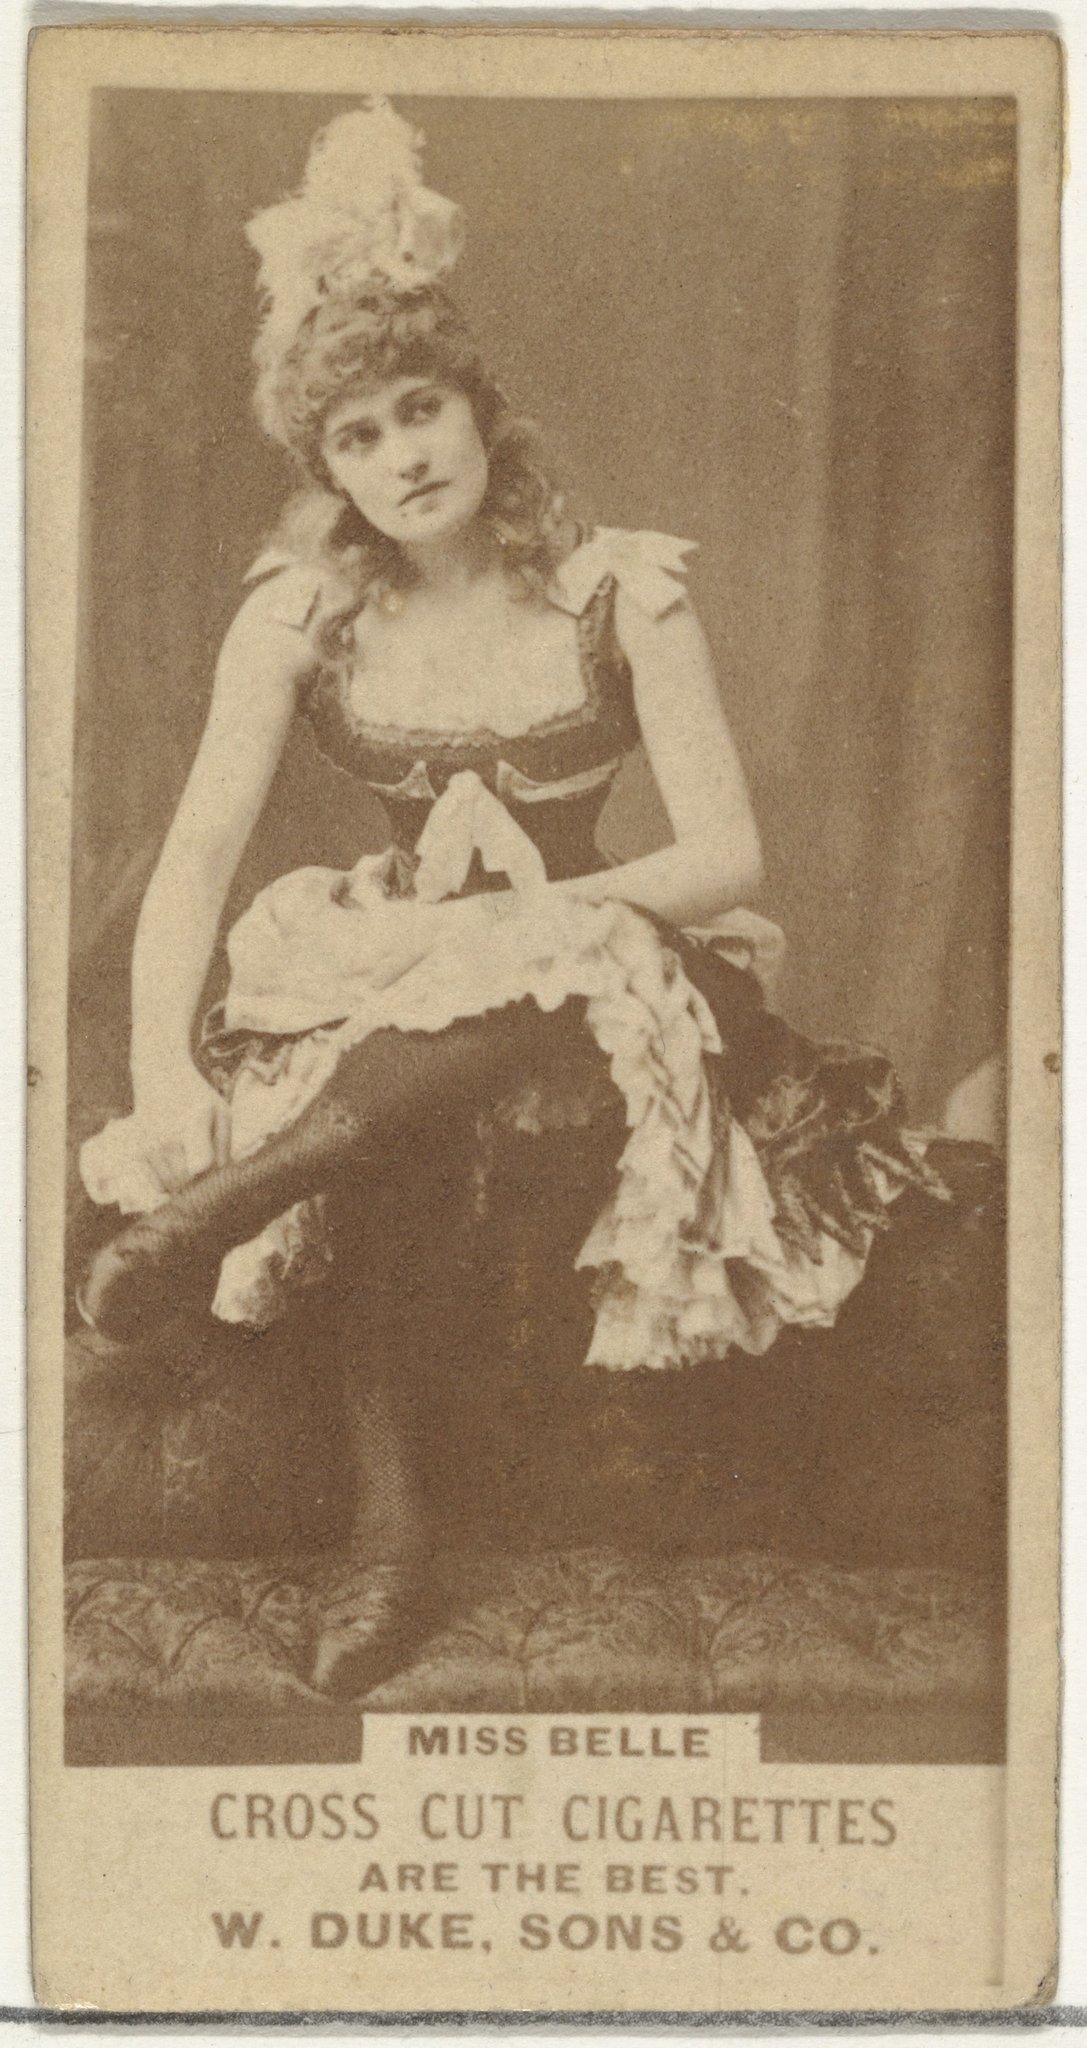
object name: photograph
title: Miss Belle, from the Actors and Actresses series (N145-3) issued by Duke Sons & Co. to promote Cross Cut Cigarettes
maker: w. duke, sons & co.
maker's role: publisher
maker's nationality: american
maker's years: 1870-1920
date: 1880-1889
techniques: albumen silver print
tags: portraits,women,actresses